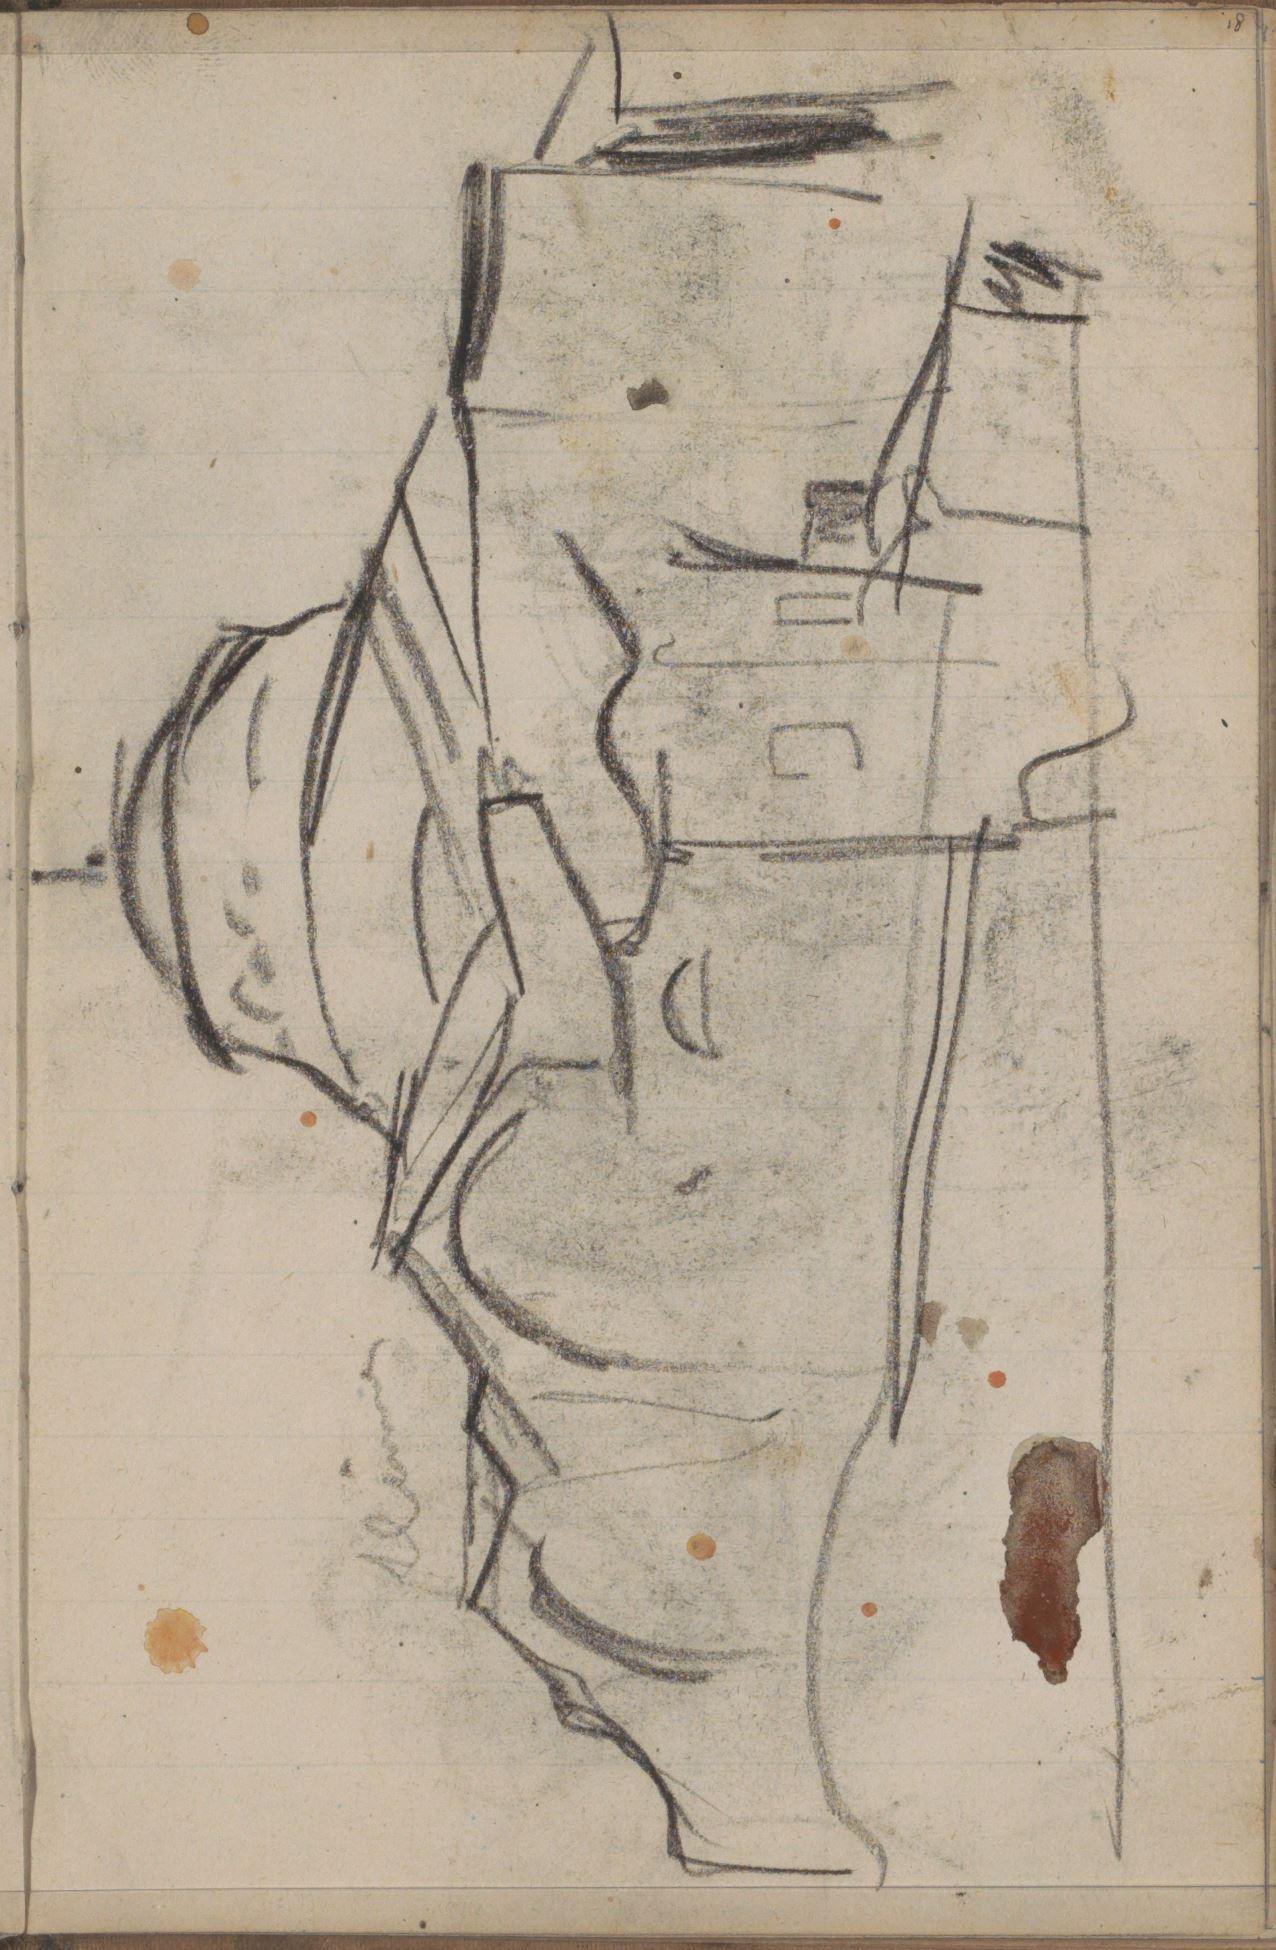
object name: sketchbook leaf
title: Gebouw met een koepeldak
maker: marius bauer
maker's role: draughtsman, print maker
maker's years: 1867-1932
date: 1888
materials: chalk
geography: istanbul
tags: architecture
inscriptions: kleurnotitie, handgeschreven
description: Pagina 18 uit een schetsboek met 56 bladen.